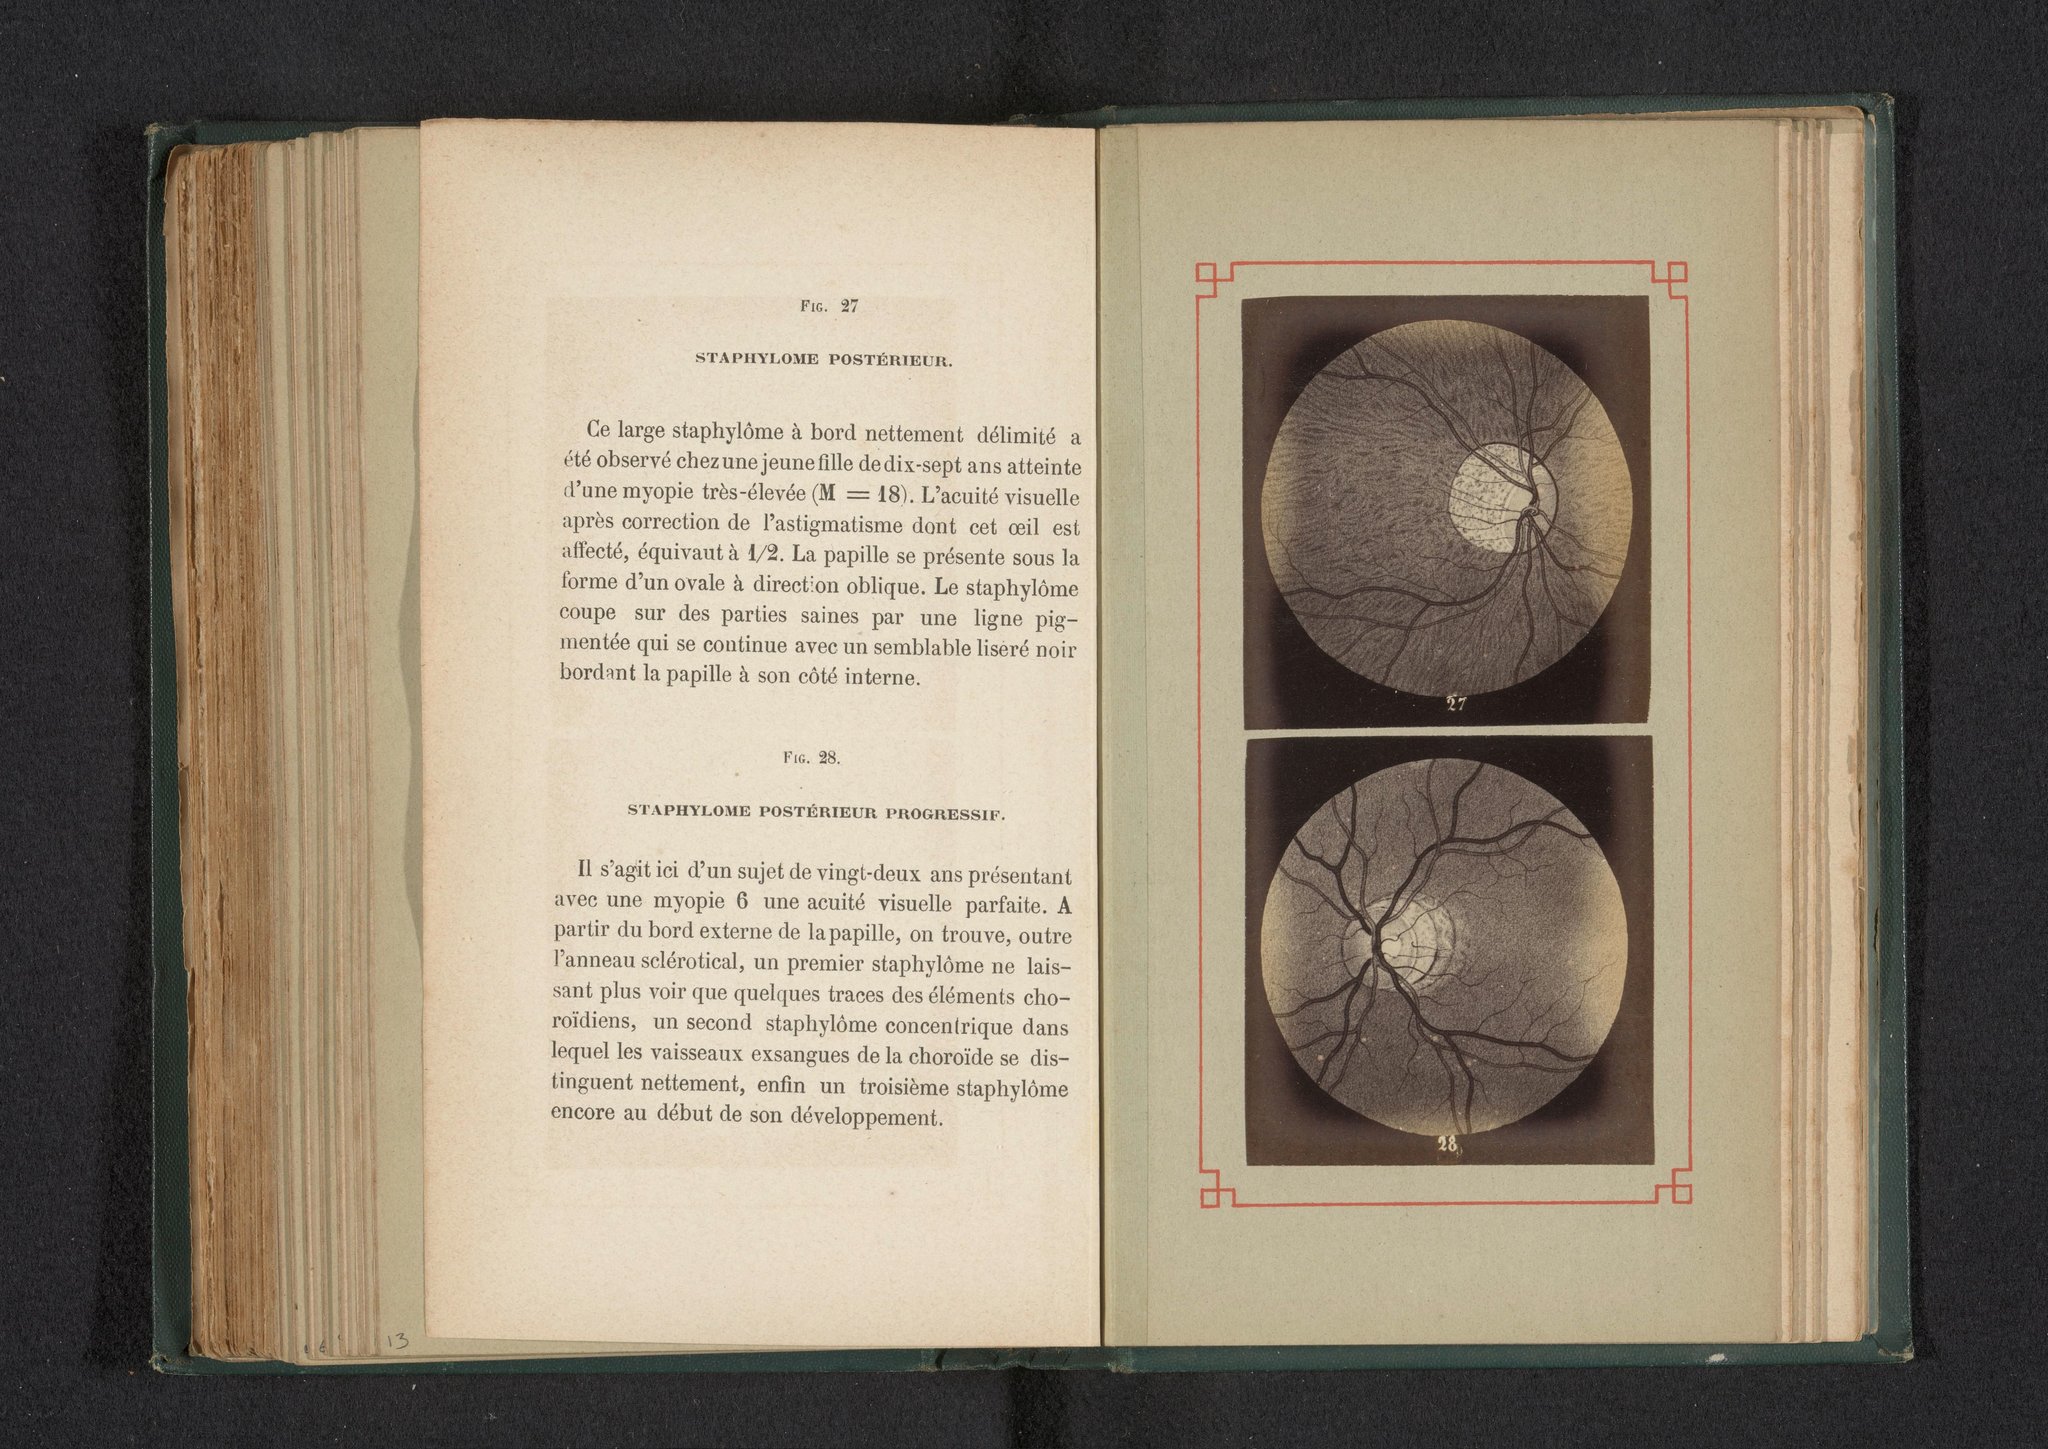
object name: reproduction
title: Fotoreproductie van twee anatomische tekeningen van stafyloom aan het oog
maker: Anonymous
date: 1871-1881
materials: photographic support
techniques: albumen print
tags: anatomy (non-medical), eyes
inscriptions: inscription: ‘Fig. 27. Staphylome postérieur. Fig. 28. Staphylome postérieur progressif.’